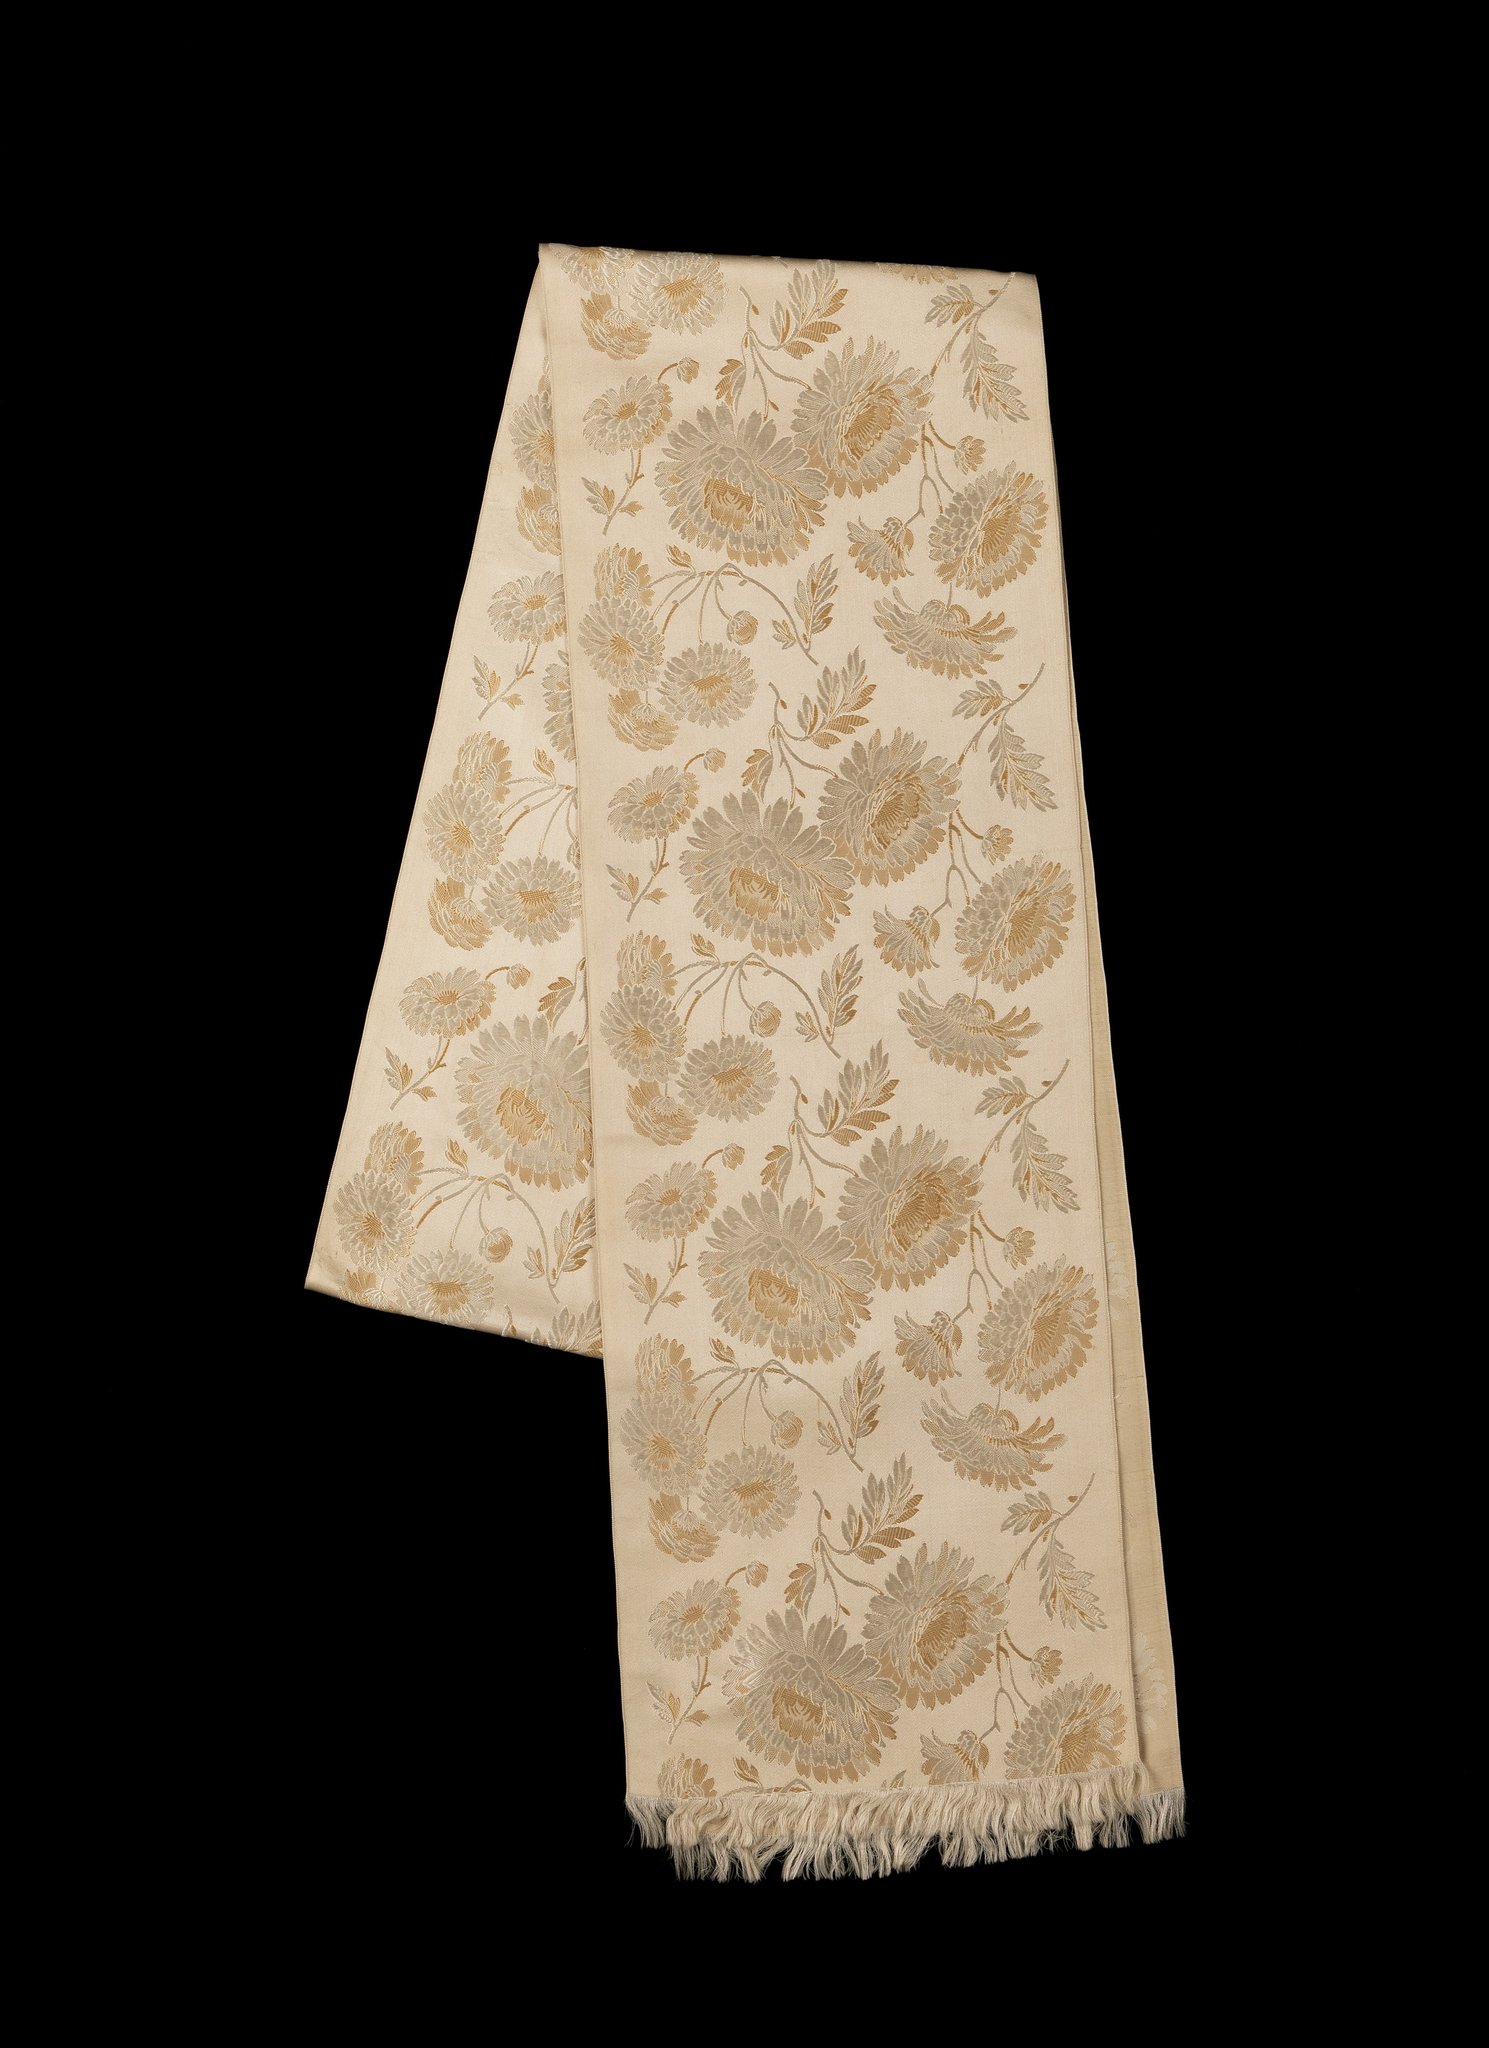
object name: wedding sash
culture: american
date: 1883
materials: silk